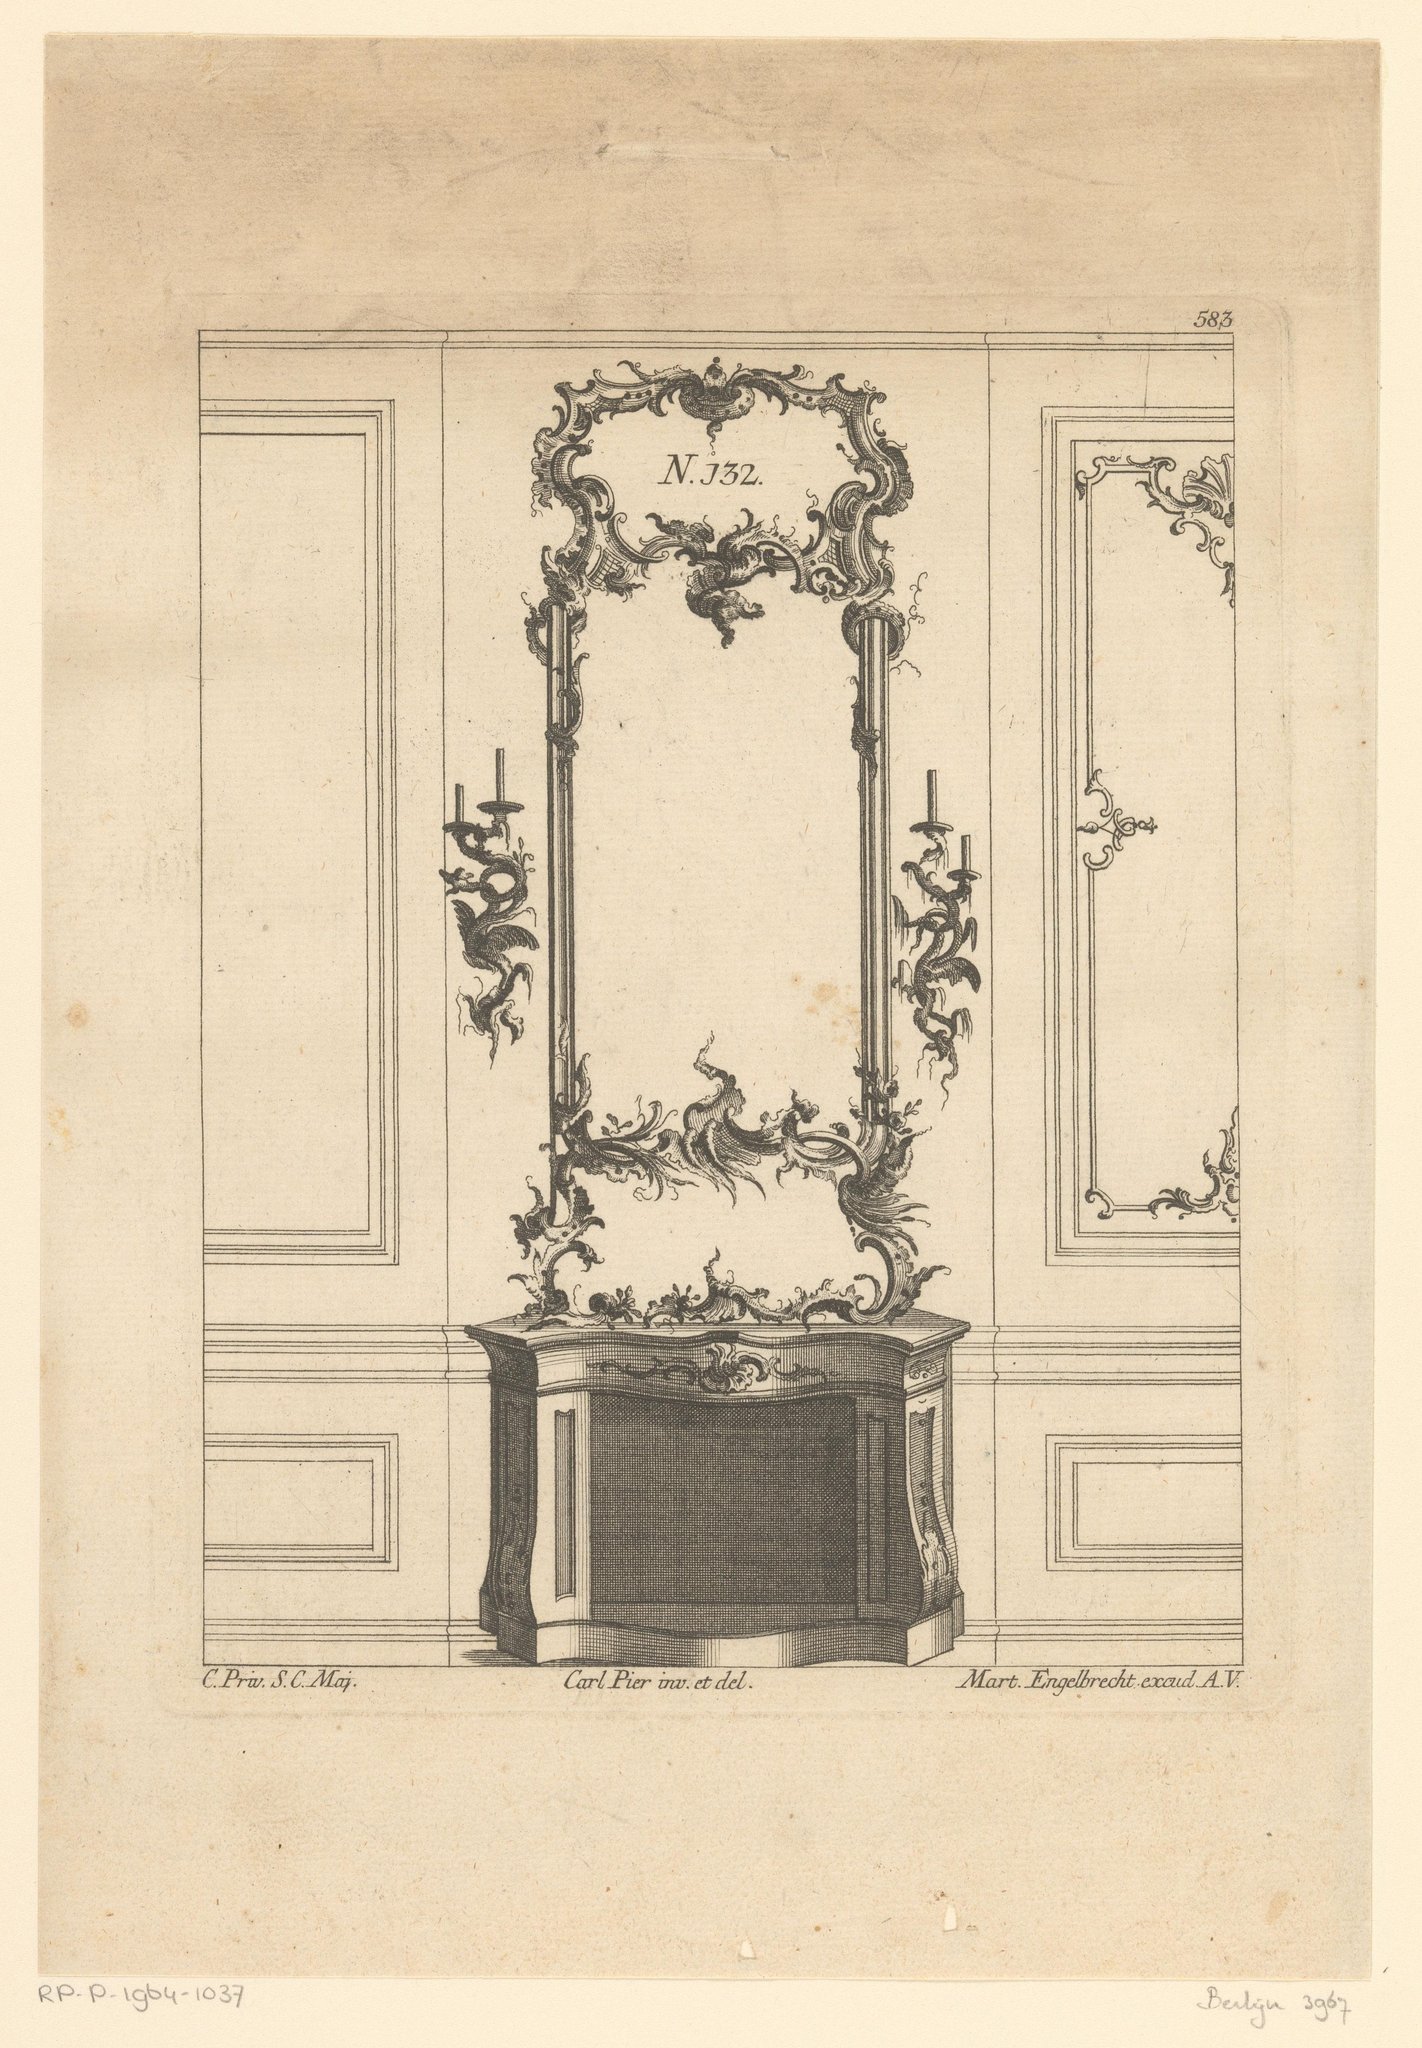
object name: ornament print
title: Wanddecoratie met schouw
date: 1748-1753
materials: paper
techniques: engraving, etching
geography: augsburg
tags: open hearth, fire-place, wall-covering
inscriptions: collector's mark: Lugt 2760, collector's mark: Lugt 2228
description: Ontwerp voor een rocaille wanddecoratie met twee tweearmige kandelaars, een schouw en halve panelen aan weerszijden. Prentnummer 583, uitgeversnummer 132.